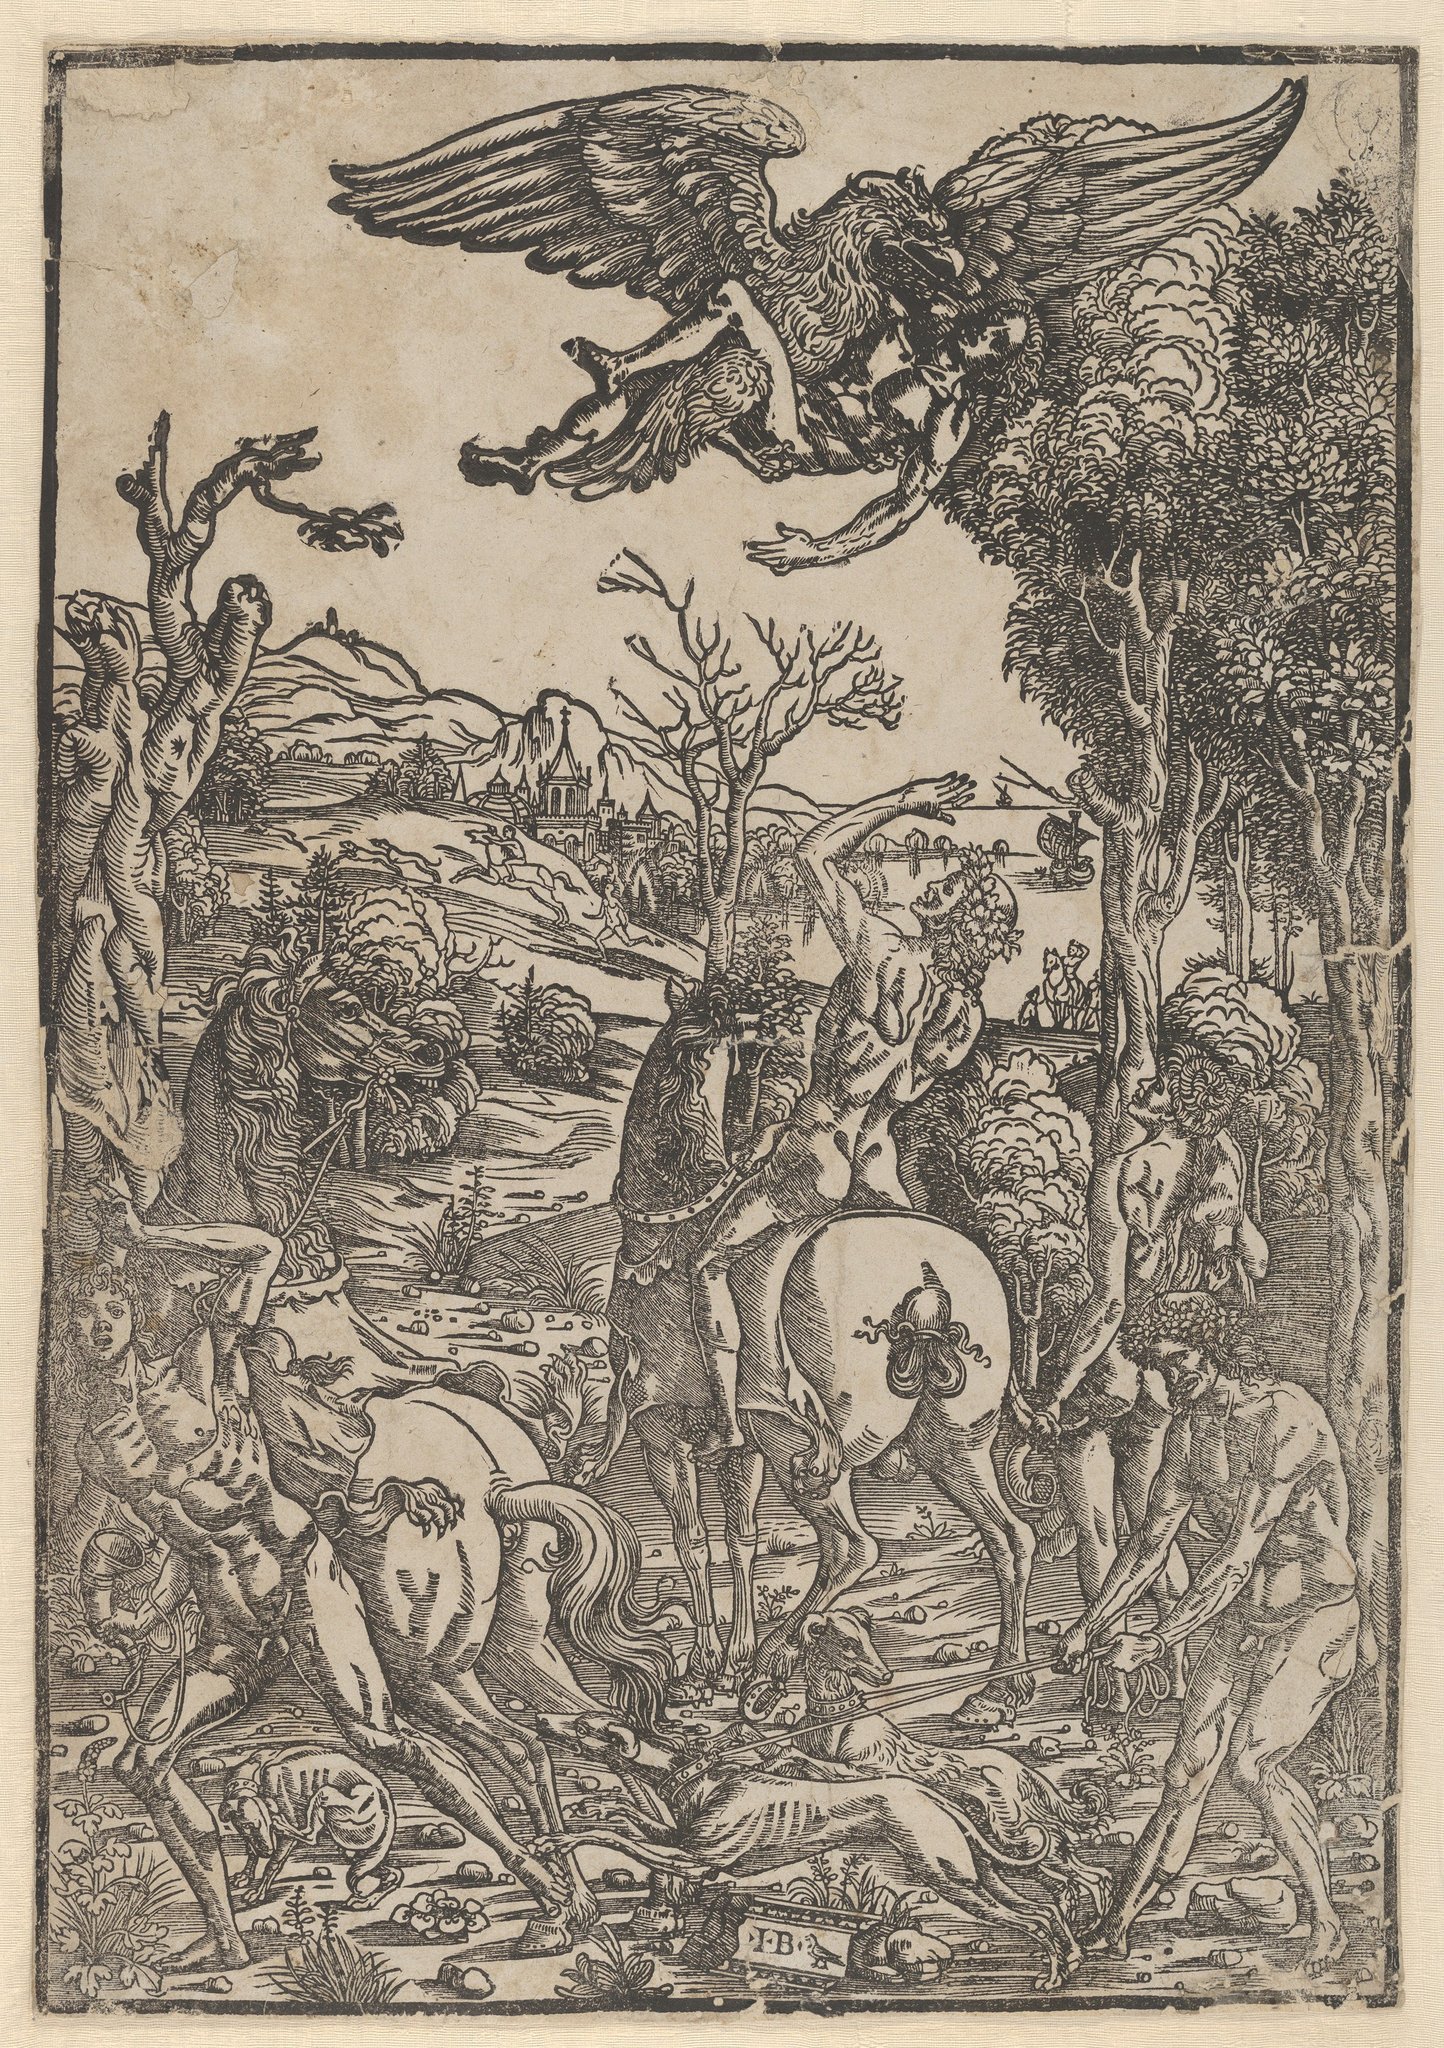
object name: print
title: Zeus as an eagle, abducting Ganymede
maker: giovanni battista palumba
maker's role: artist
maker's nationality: italian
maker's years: 1495-1520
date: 1500-1510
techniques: woodcut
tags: eagles,male nudes,horses,trees